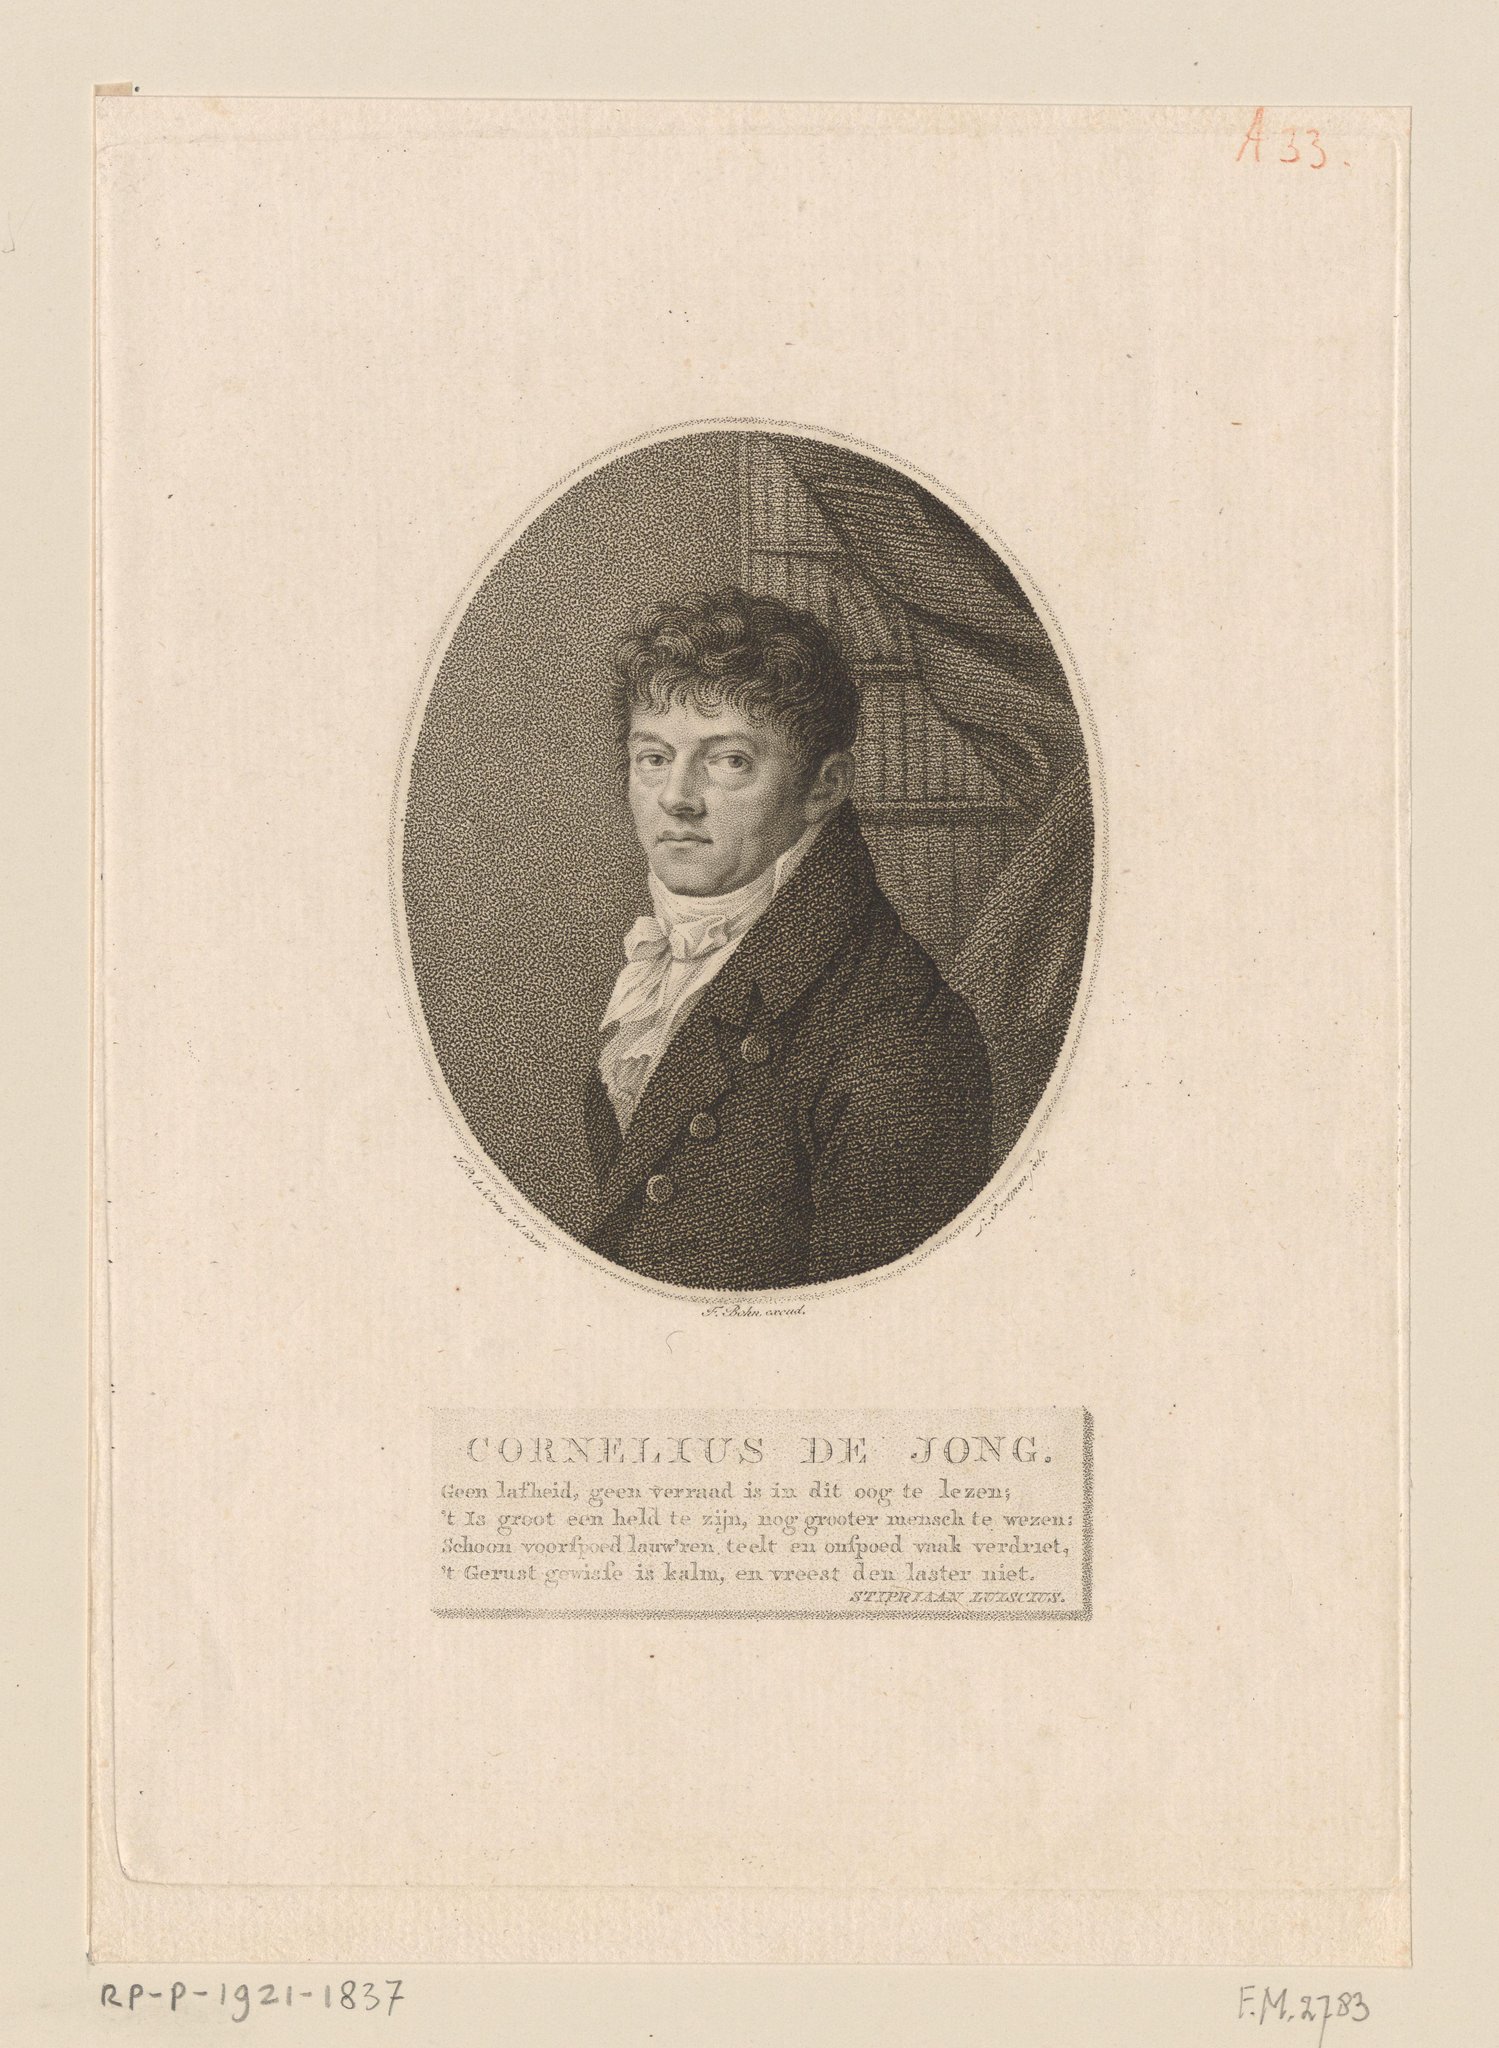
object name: print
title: Portret van Cornelius de Jong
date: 1789-1819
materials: paper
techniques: etching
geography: haarlem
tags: the hague, historical persons, seaman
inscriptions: collector's mark: Lugt 2233